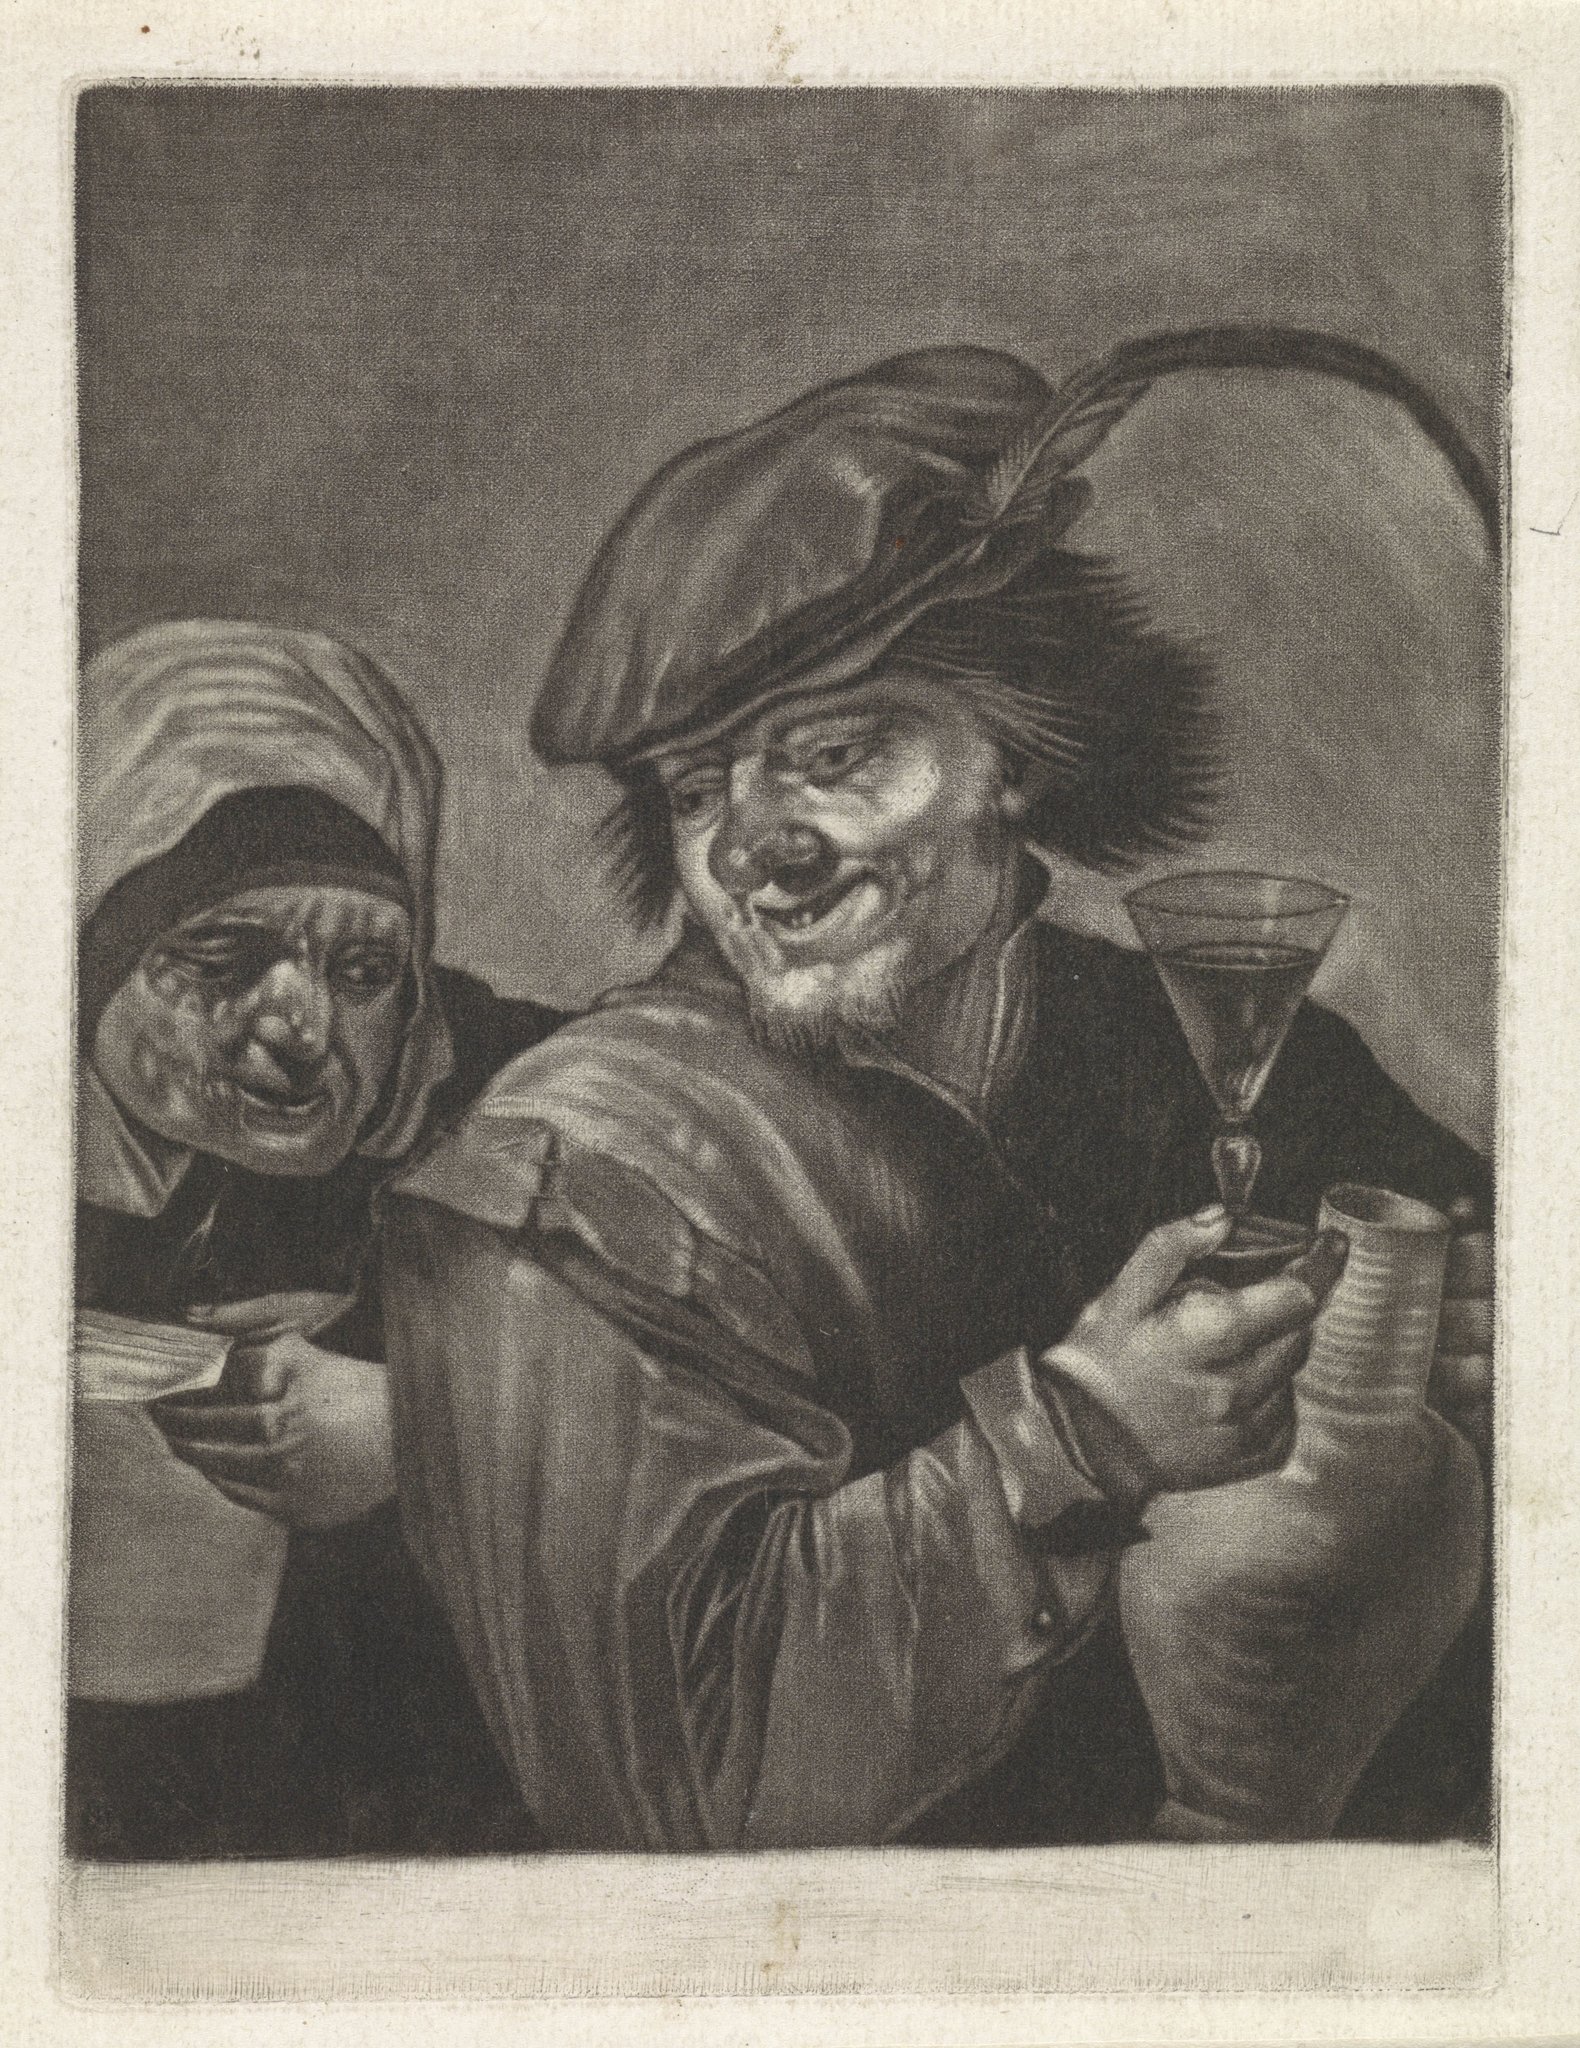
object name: print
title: Man met kan en wijnglas (variant A)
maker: jan van der bruggen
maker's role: draughtsman, print maker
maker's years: 1649-1709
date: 1659-1740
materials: paper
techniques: mezzotint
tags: jar, jug (used as drinking-vessel), wine ~ alcoholic drinks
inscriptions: collector's mark: Lugt 2228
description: Een man houdt een kan en een wijnglas in de handen. Achter hem een oude vrouw met een papier in de hand.